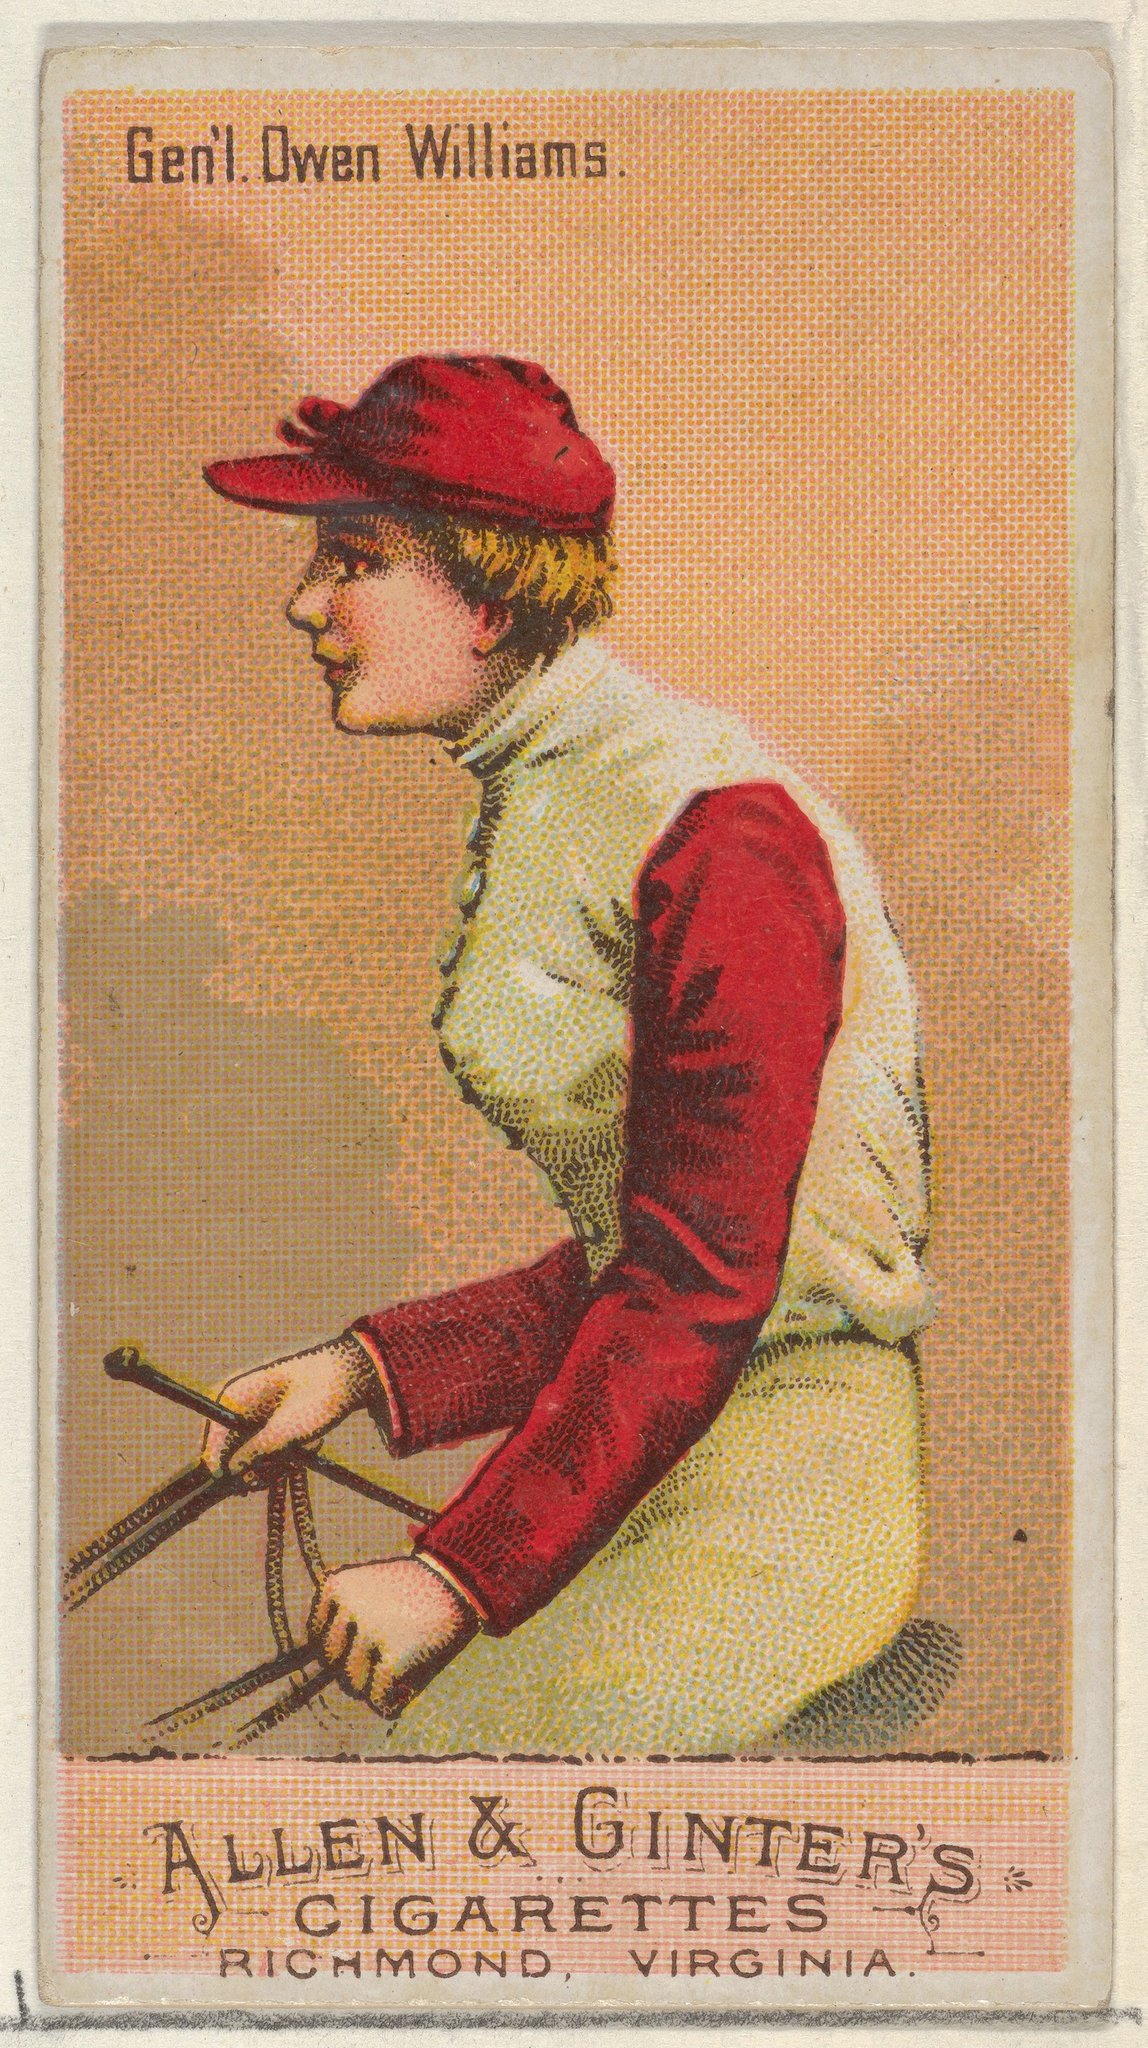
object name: print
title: General Owen Williams, from the Racing Colors of the World series (N22a) for Allen & Ginter Cigarettes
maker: allen & ginter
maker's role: publisher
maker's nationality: american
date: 1888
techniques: color lithograph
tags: profiles,women,jockeys